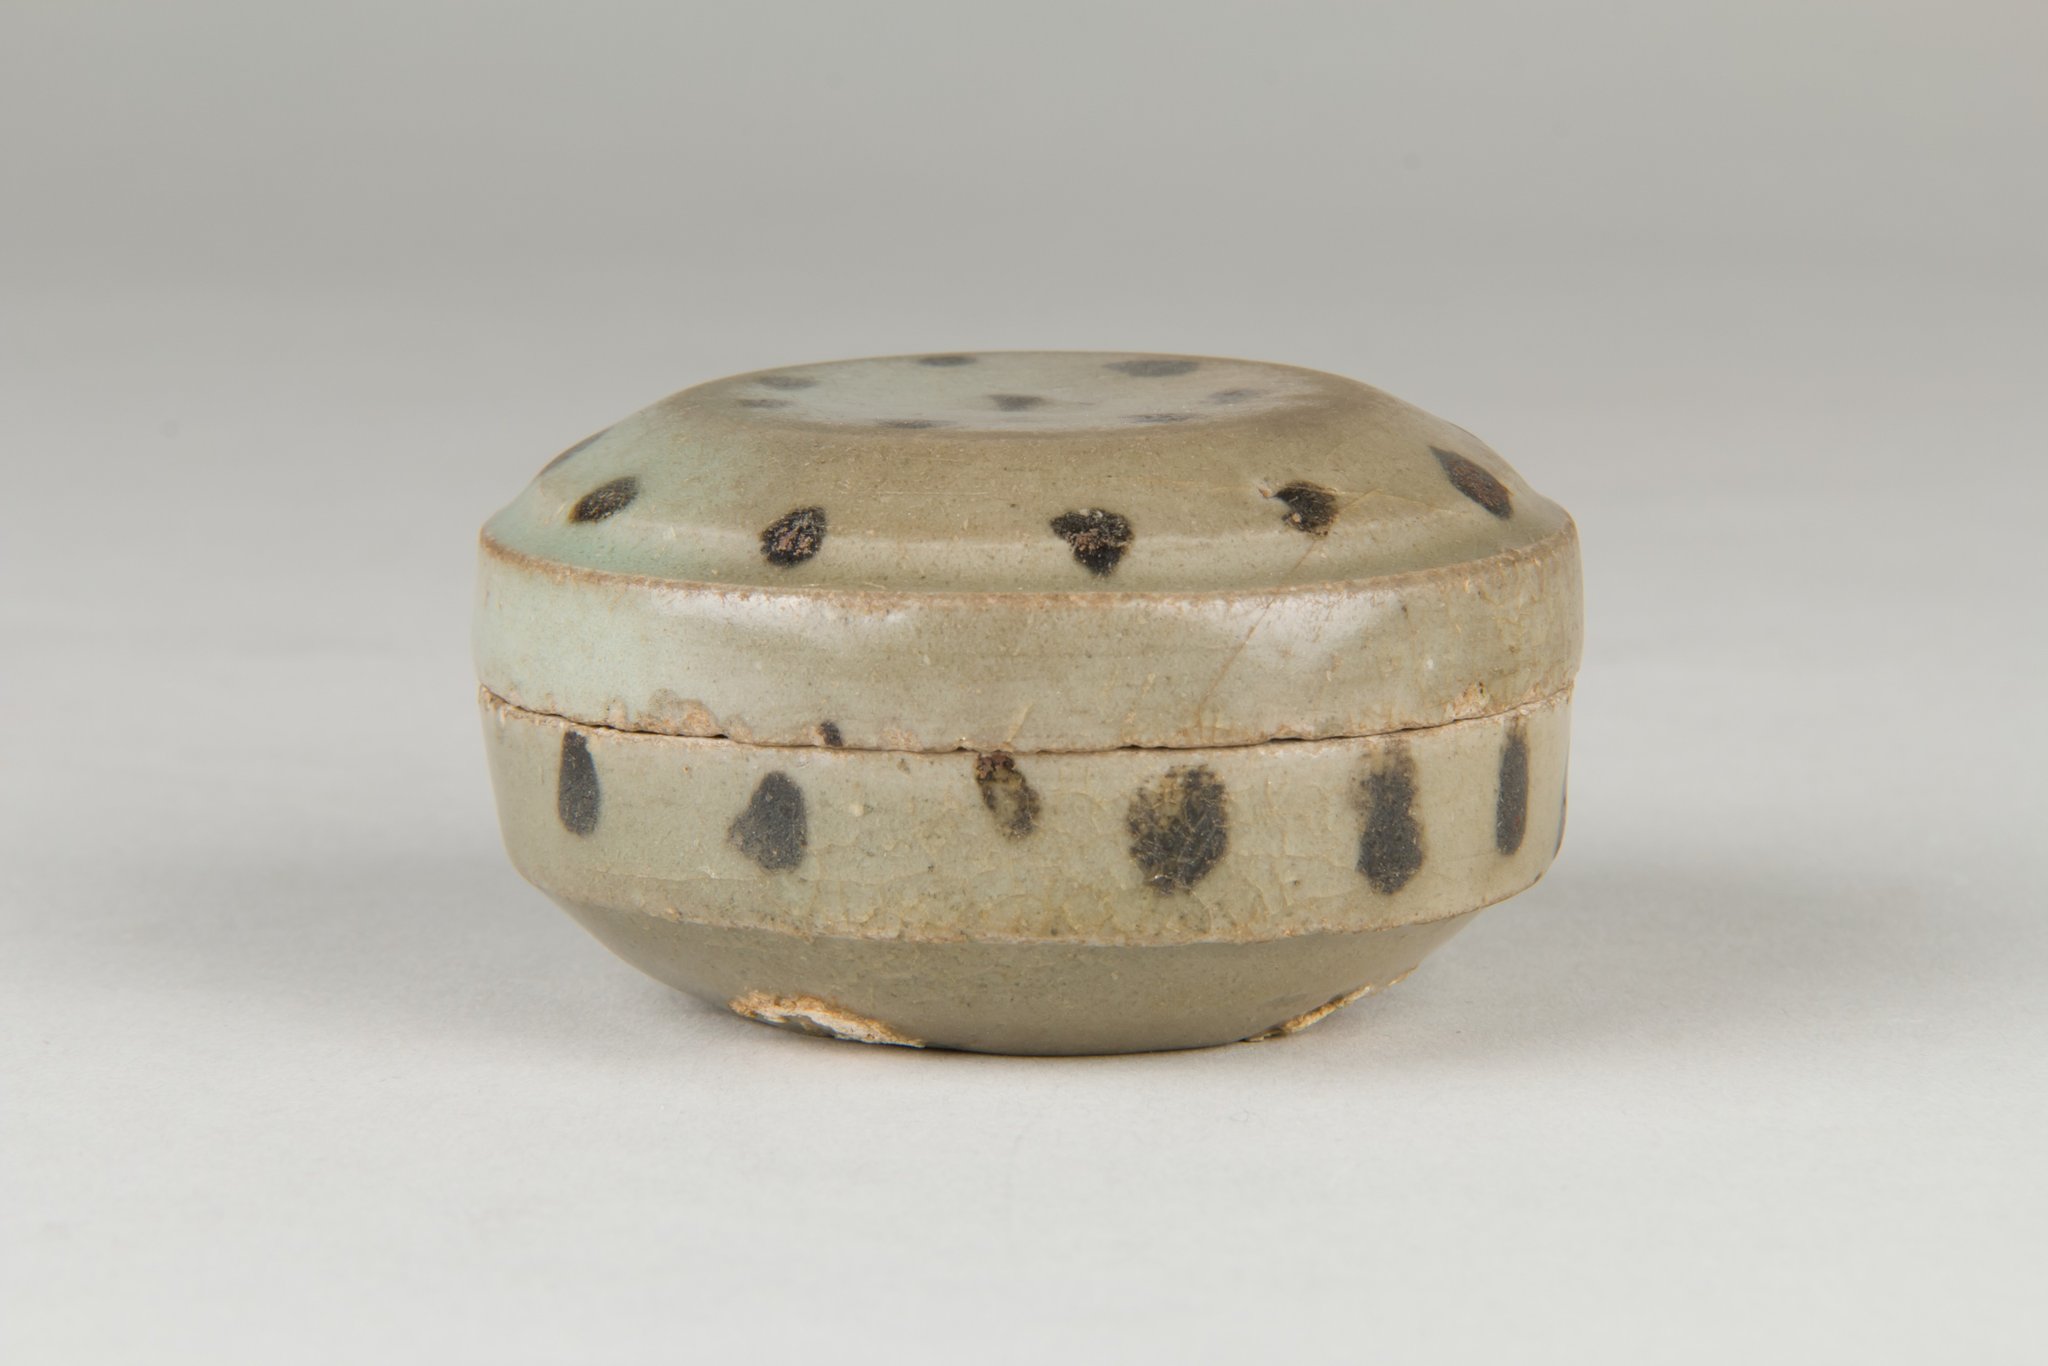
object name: box with cover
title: Box and Cover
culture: korean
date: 1201-1300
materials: clay